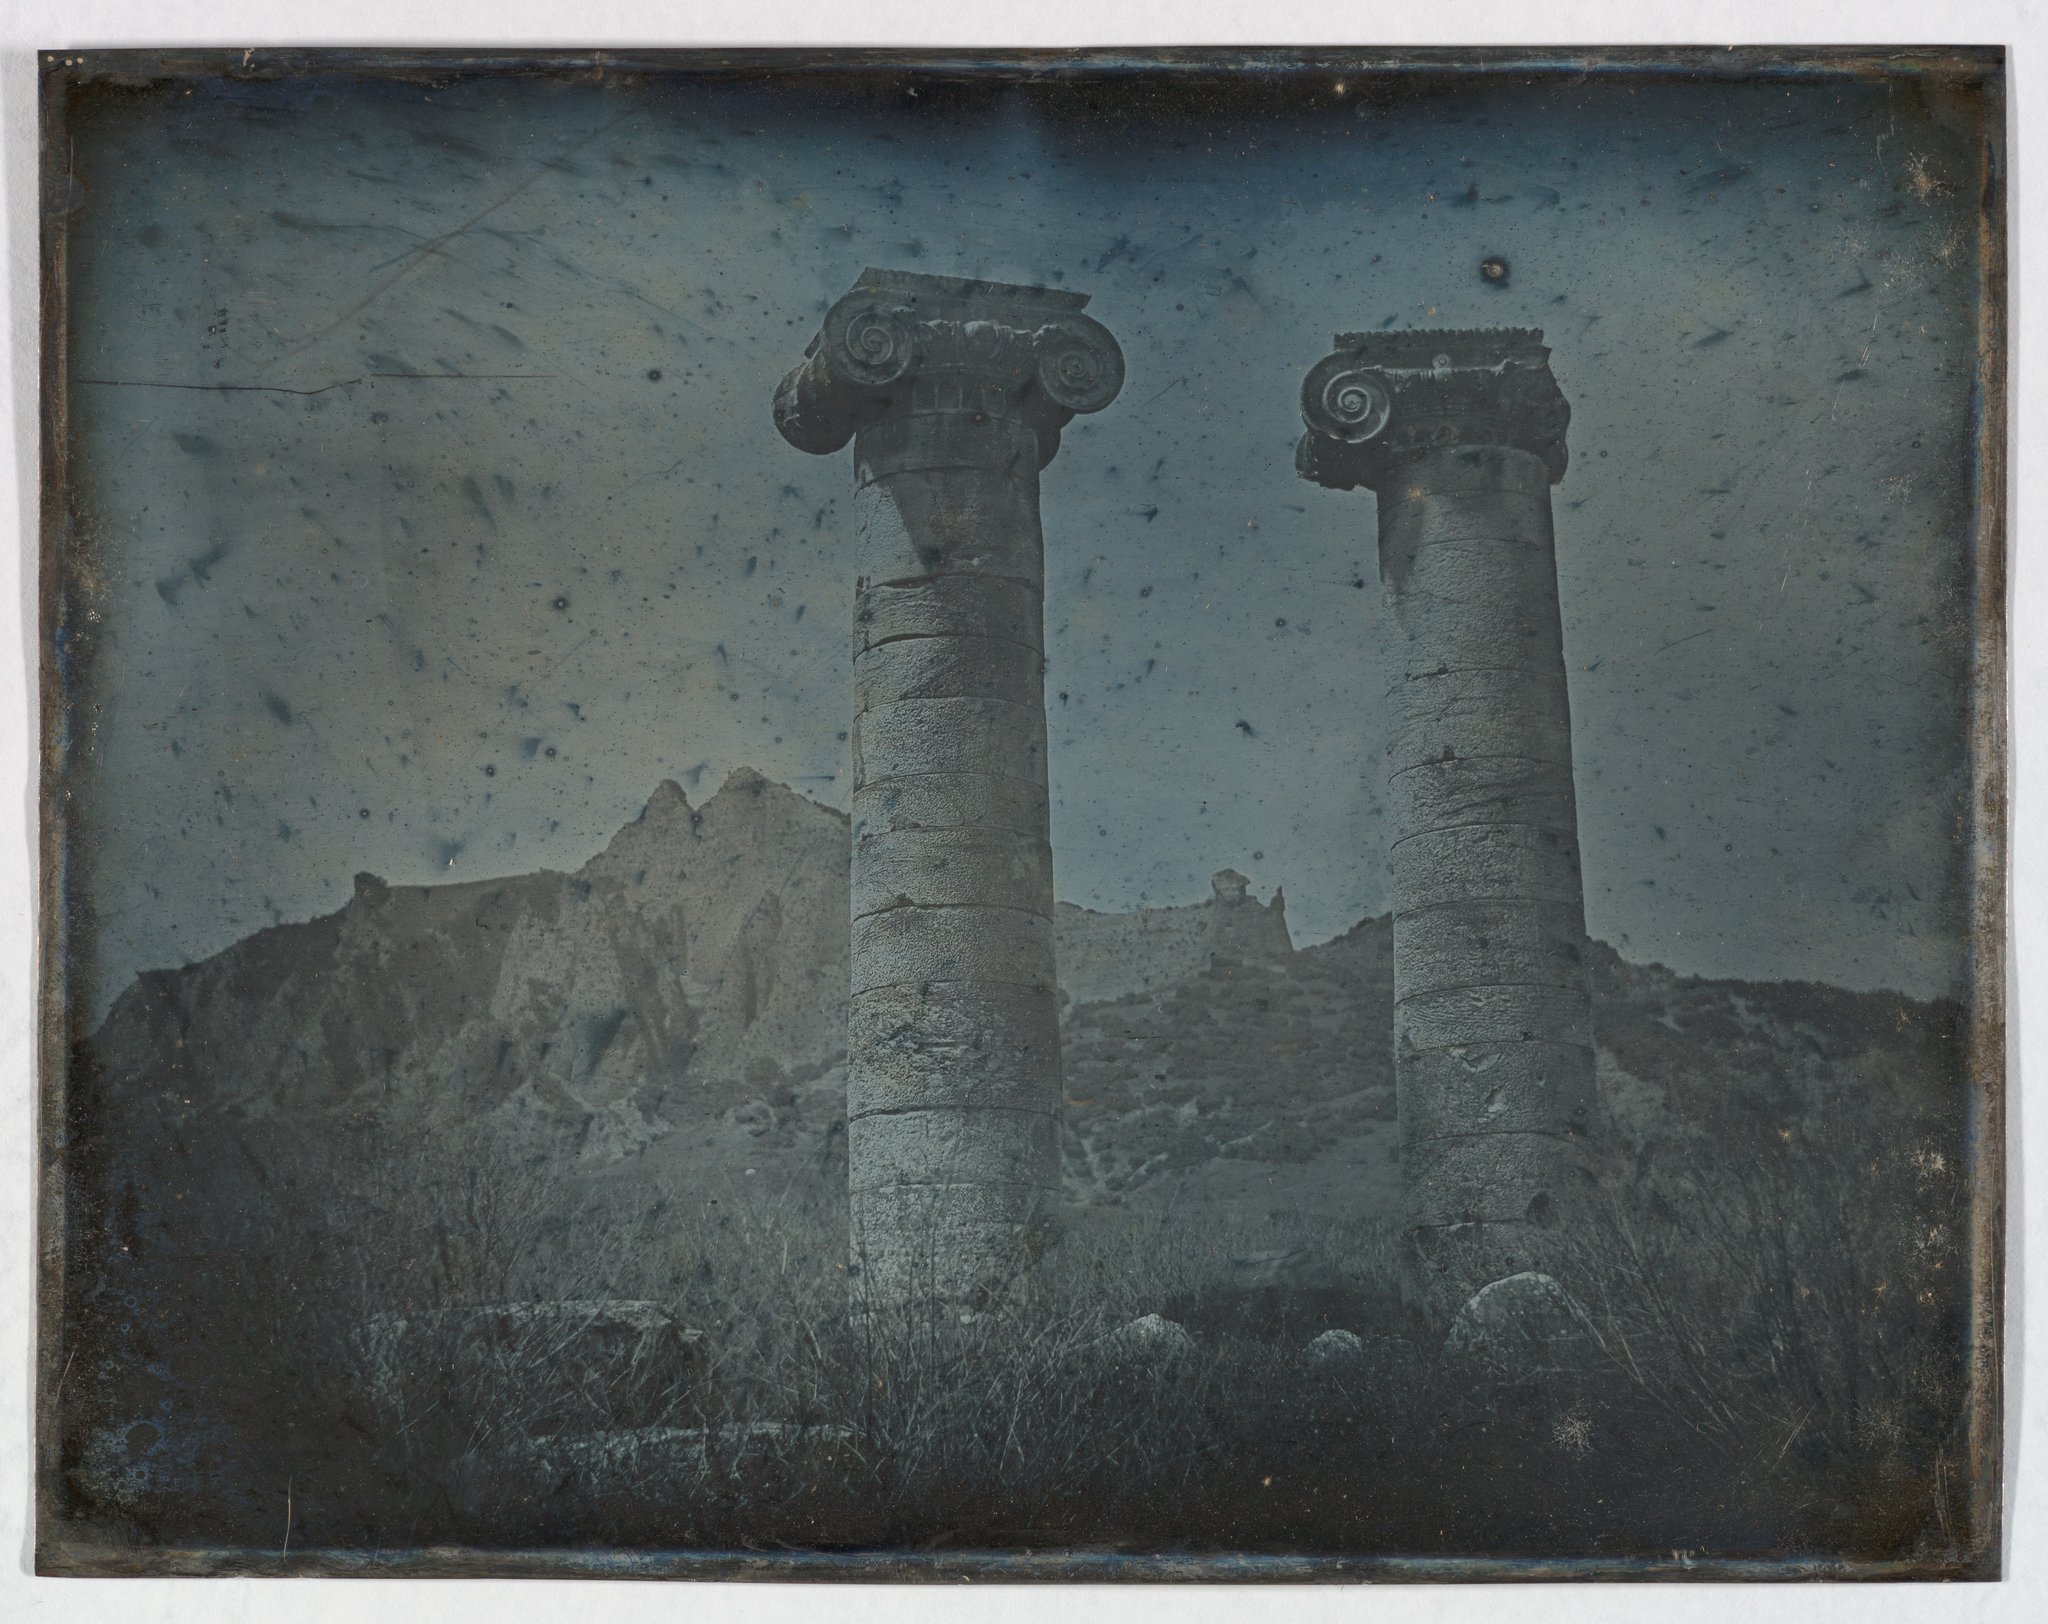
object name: photograph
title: Temple of Artemis, Sardis (134. Sardes. 1843. T. de Cybèle.)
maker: joseph-philibert girault de prangey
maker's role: artist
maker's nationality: french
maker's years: 1804-1892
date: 1843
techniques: daguerreotype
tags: columns,ruins